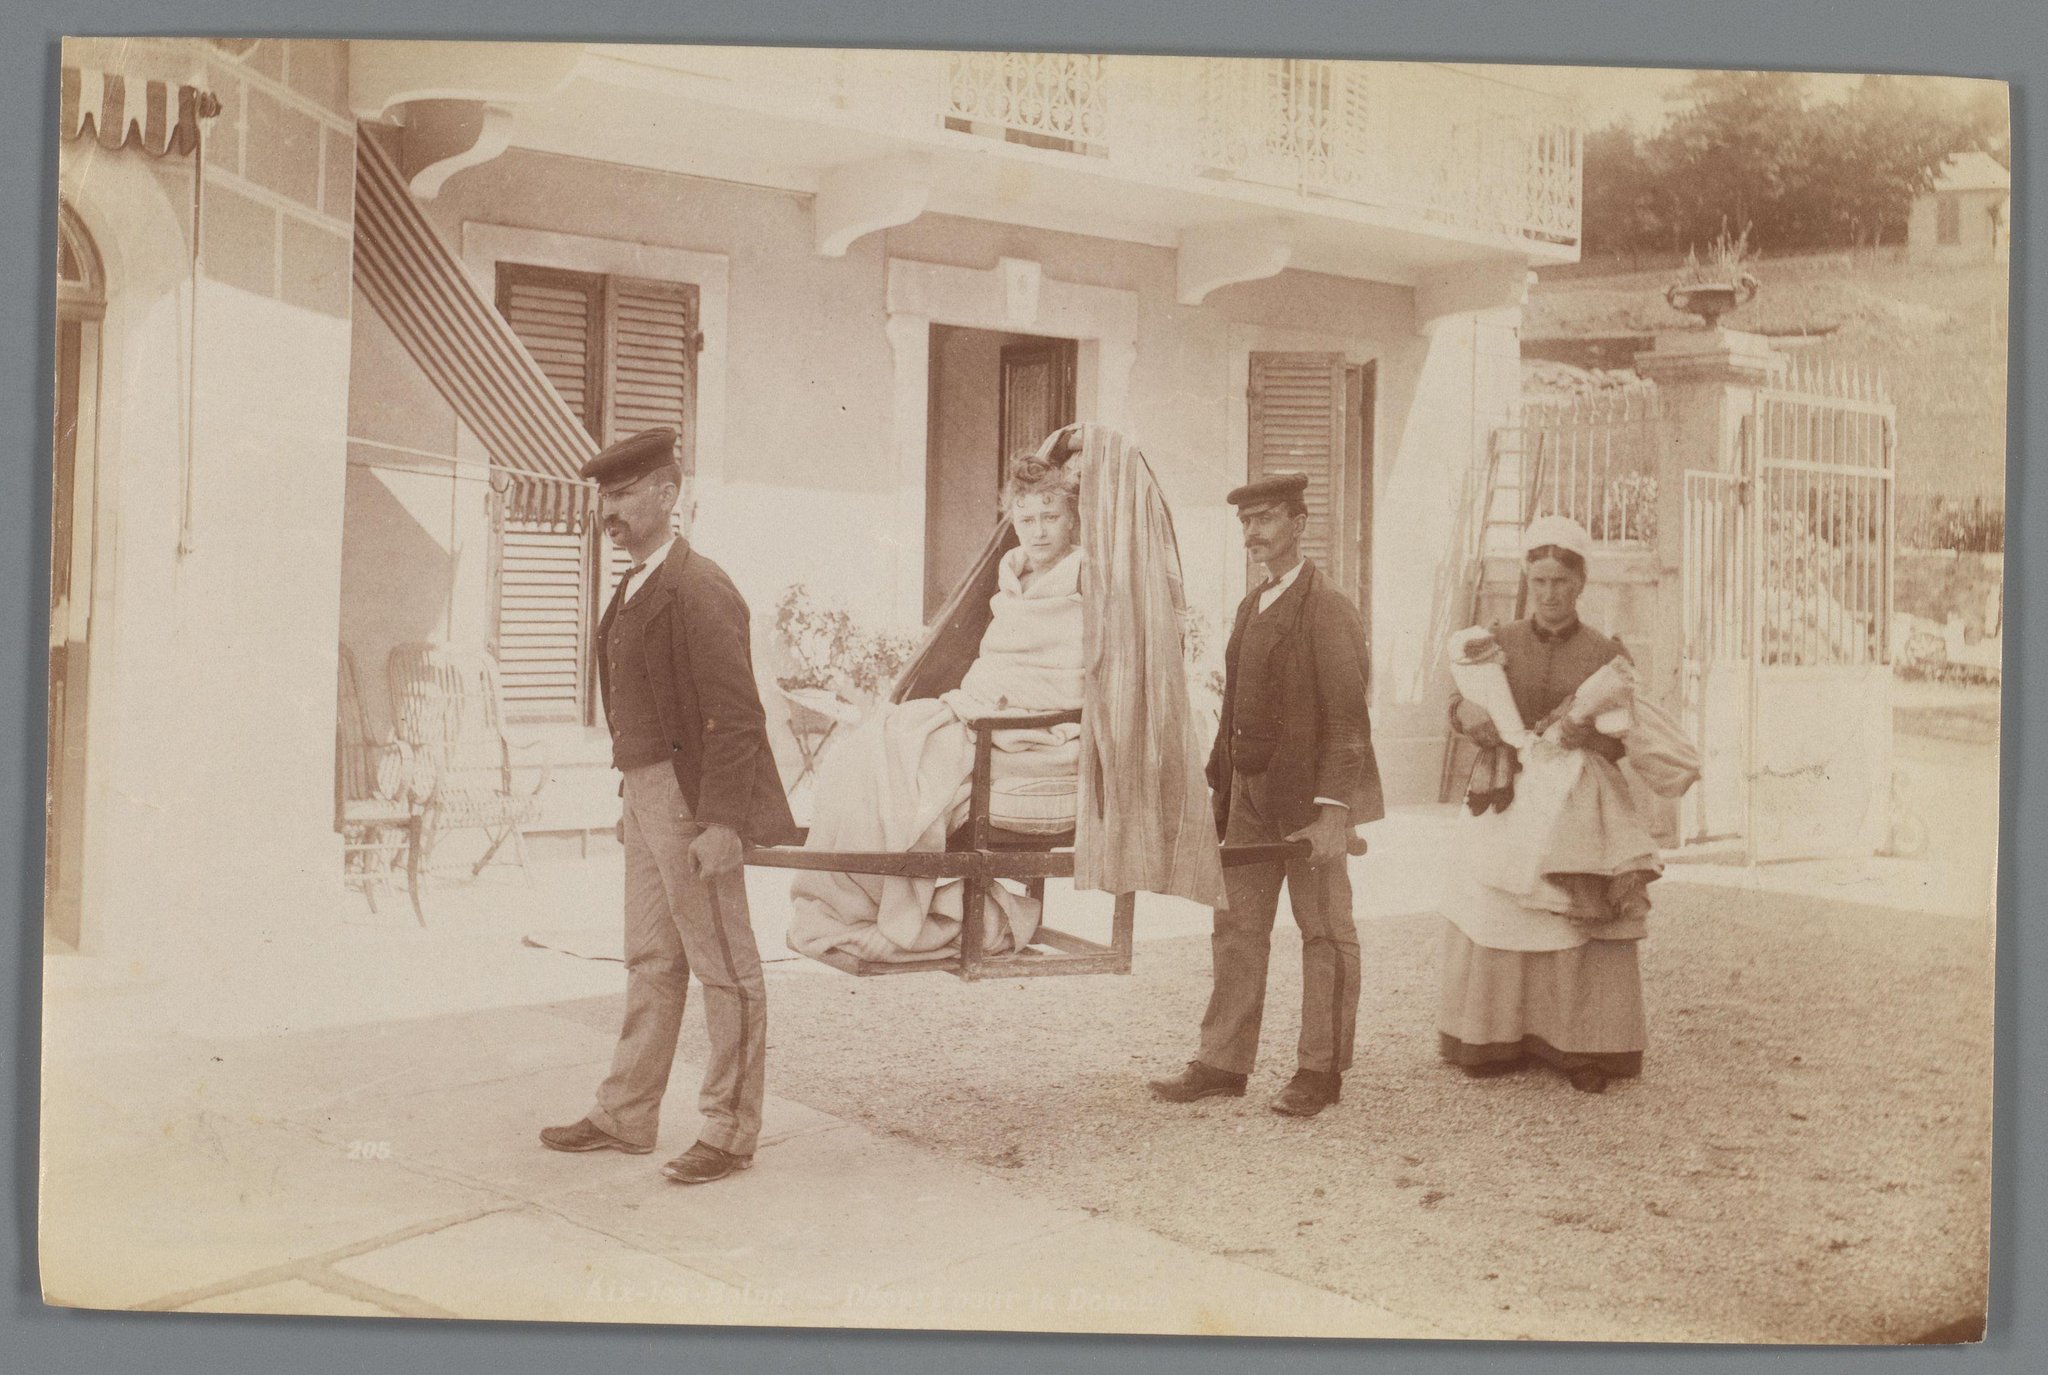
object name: photograph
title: Vrouw wordt gedragen in een draagstoel om te gaan baden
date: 1863-1900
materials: paper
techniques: albumen print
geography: aix-les-bains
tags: taking a bath, (carrying a person in a) sedan-chair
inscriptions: number: ‘205’, inscription: ‘18[...]’, inscription: ‘N.D. Phot’